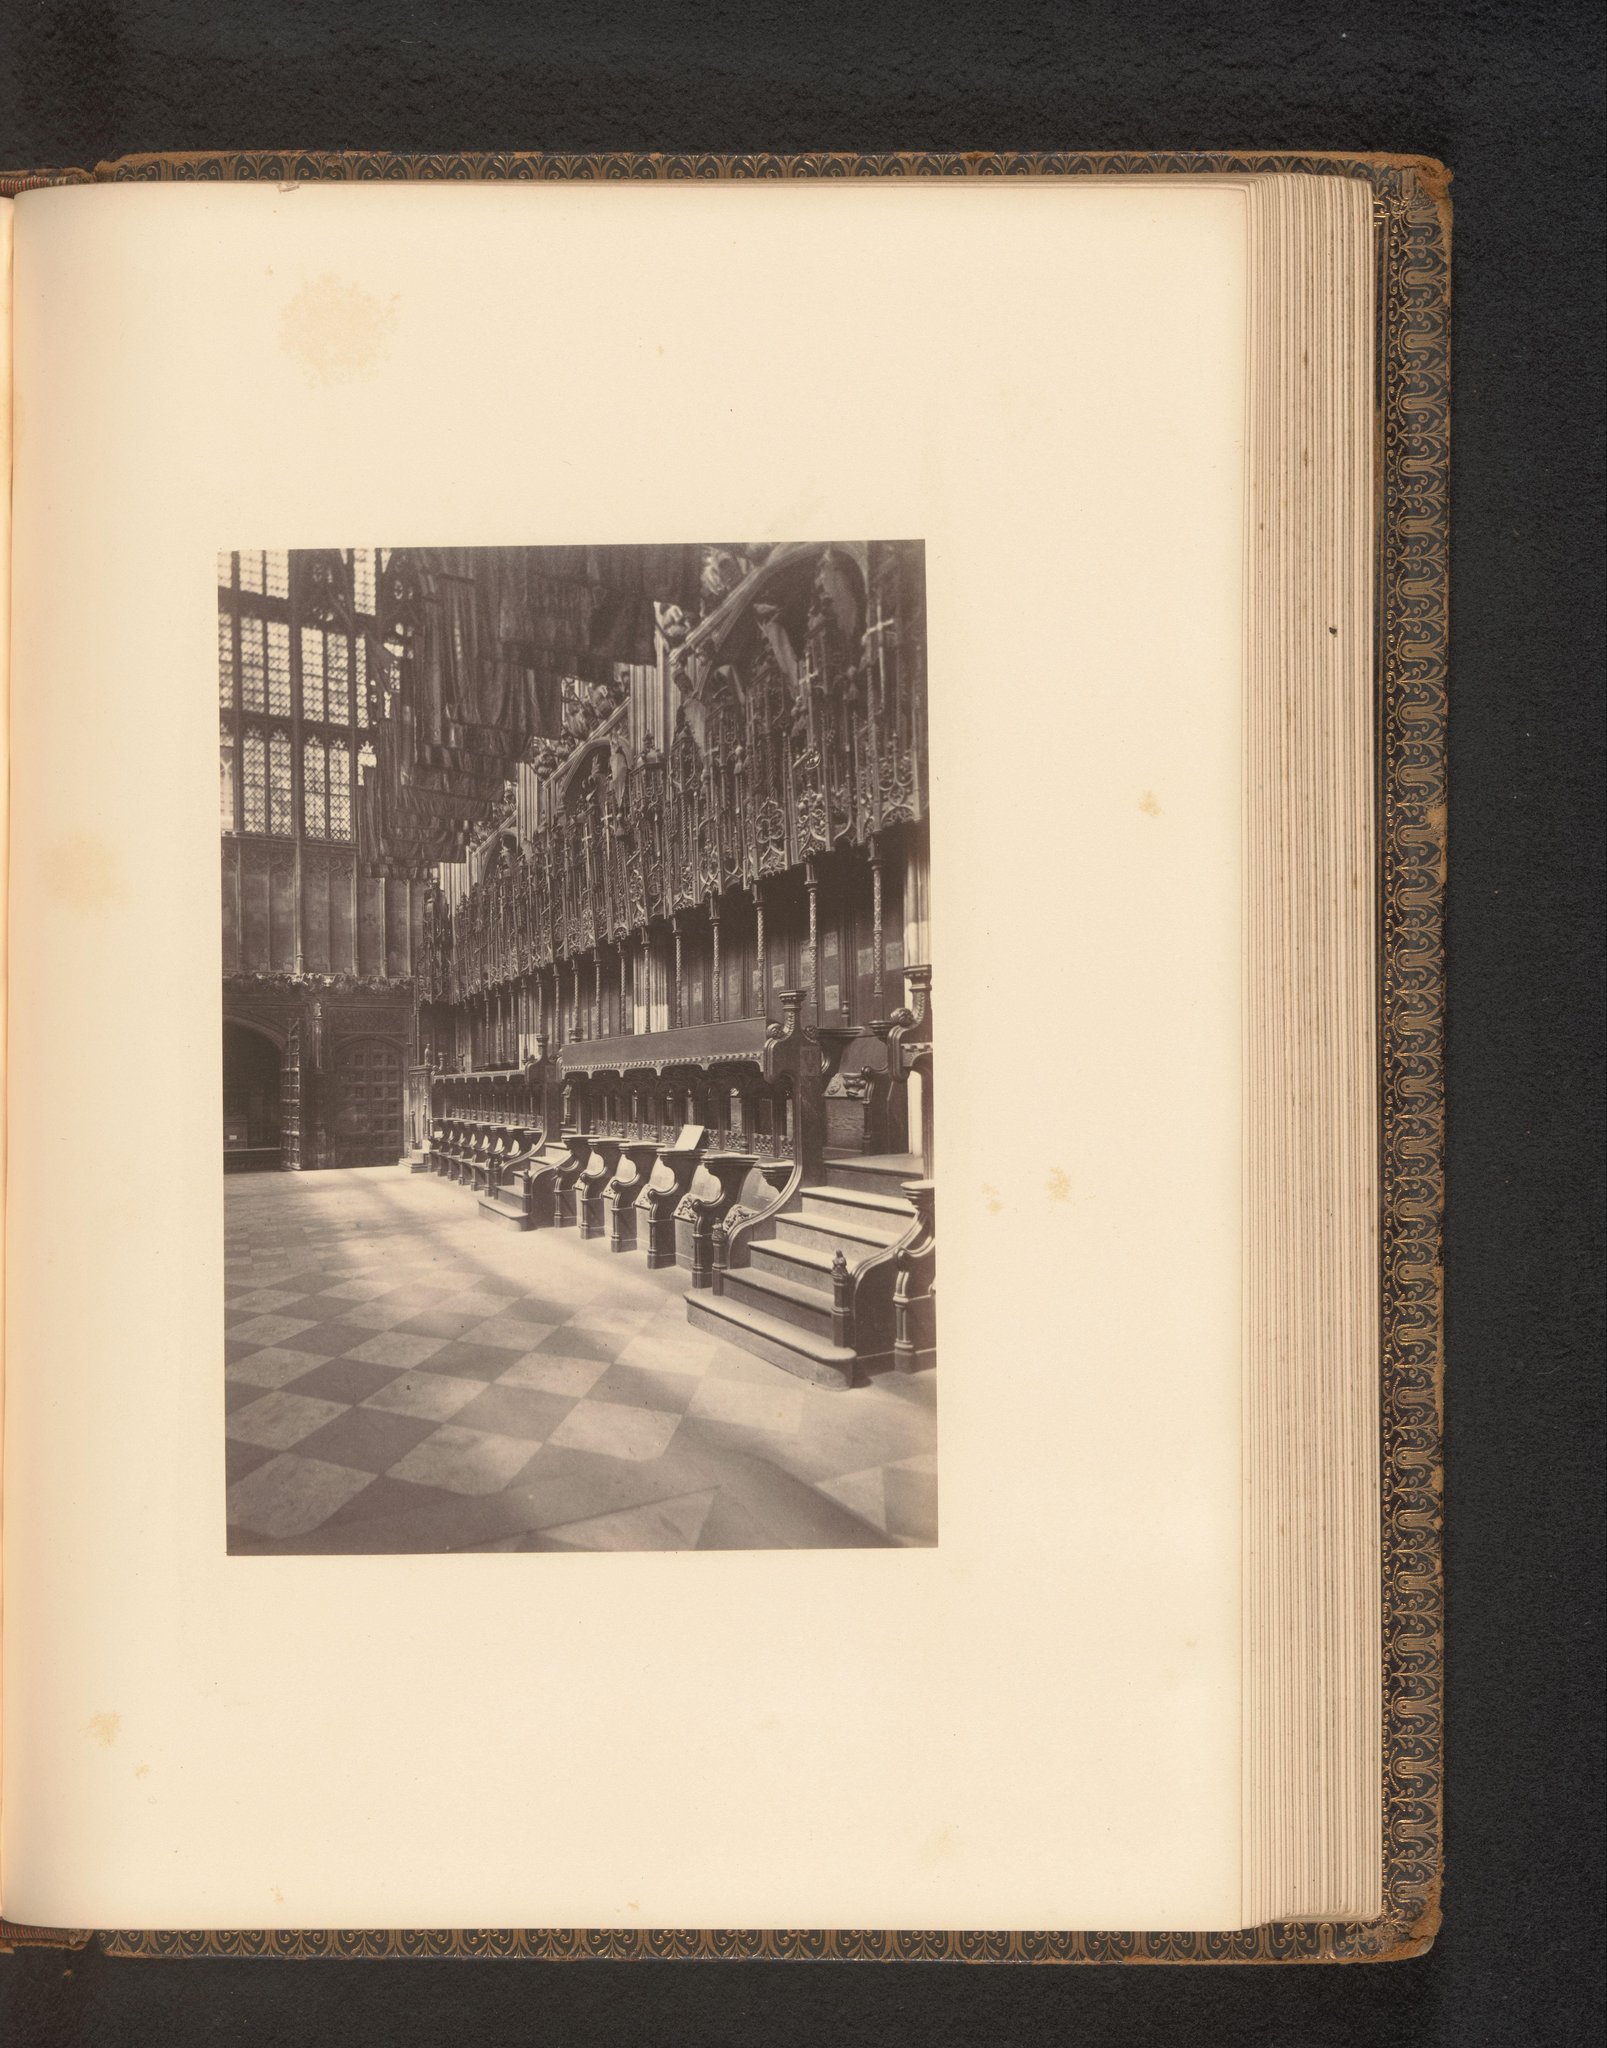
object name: photograph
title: Kapel van Henry VII te Westminster Abbey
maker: john harrington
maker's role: fotograaf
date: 1864-1869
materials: photographic support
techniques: albumen print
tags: abbey, monastery, convent ~ roman catholic church, interior of church, parts of church interior: chapel, westminster abbey